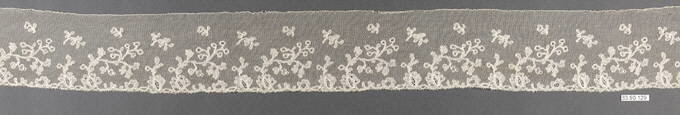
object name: edging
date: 1750-1800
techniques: lace